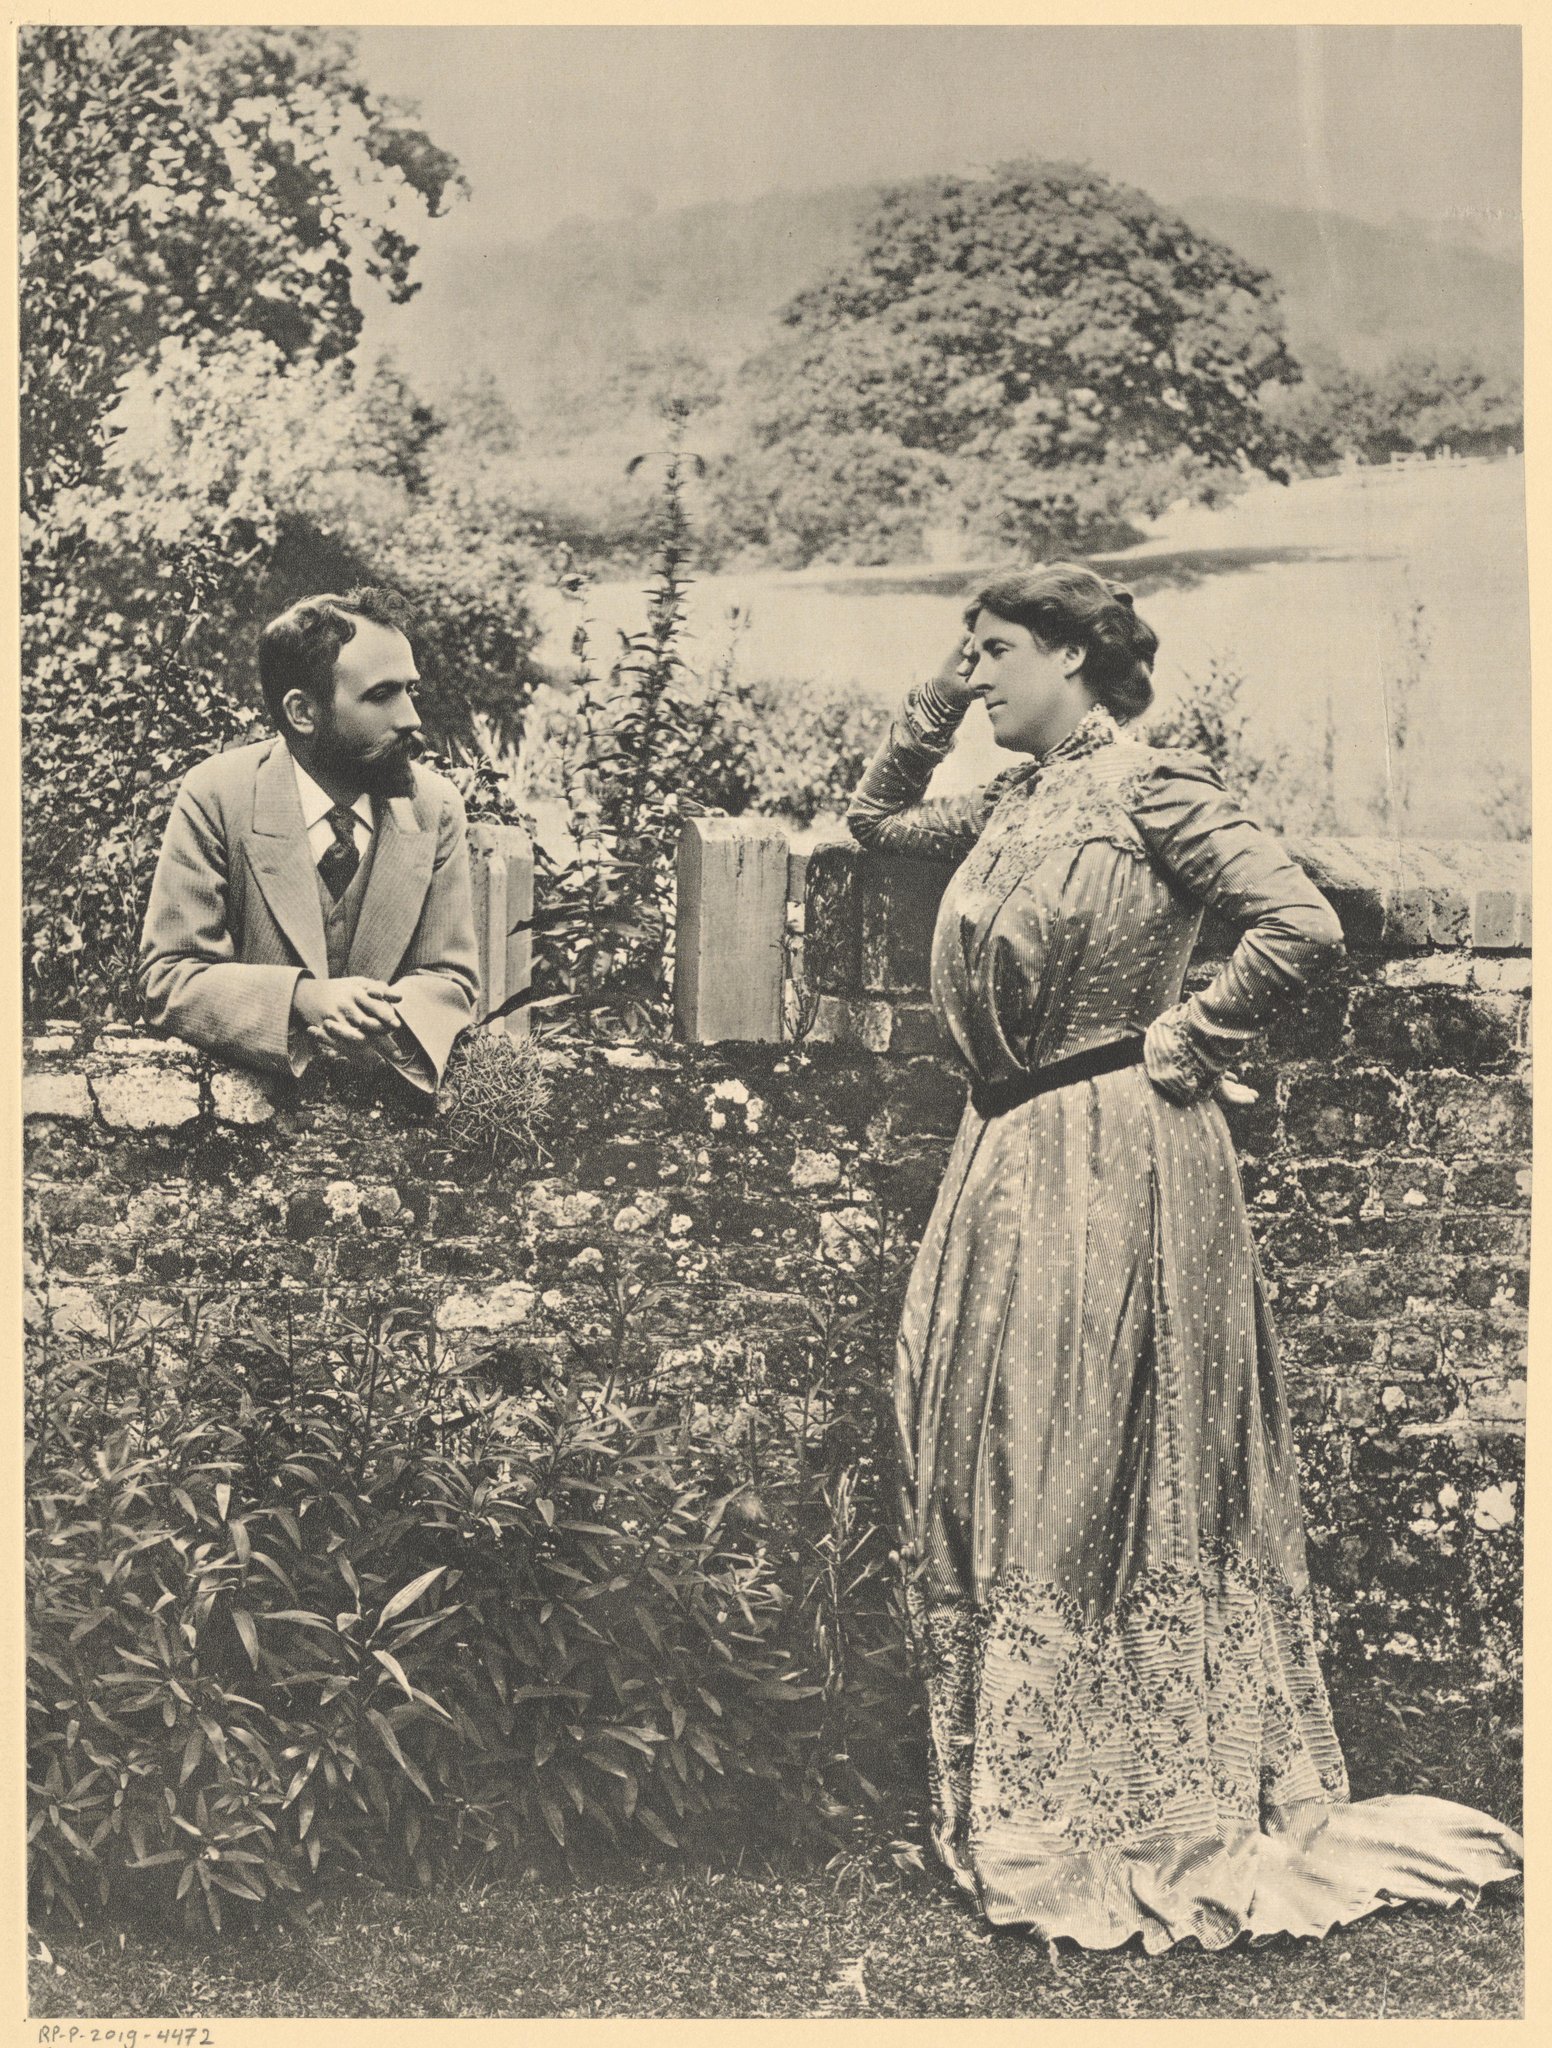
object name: photomechanical print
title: Dubbelportret van Bernard Berenson en zijn vrouw Mary in een tuin in Fernhurst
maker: Anonymous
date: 1900-1930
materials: paper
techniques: letterpress printing, rotogravure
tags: historical persons - bb - woman, historical persons